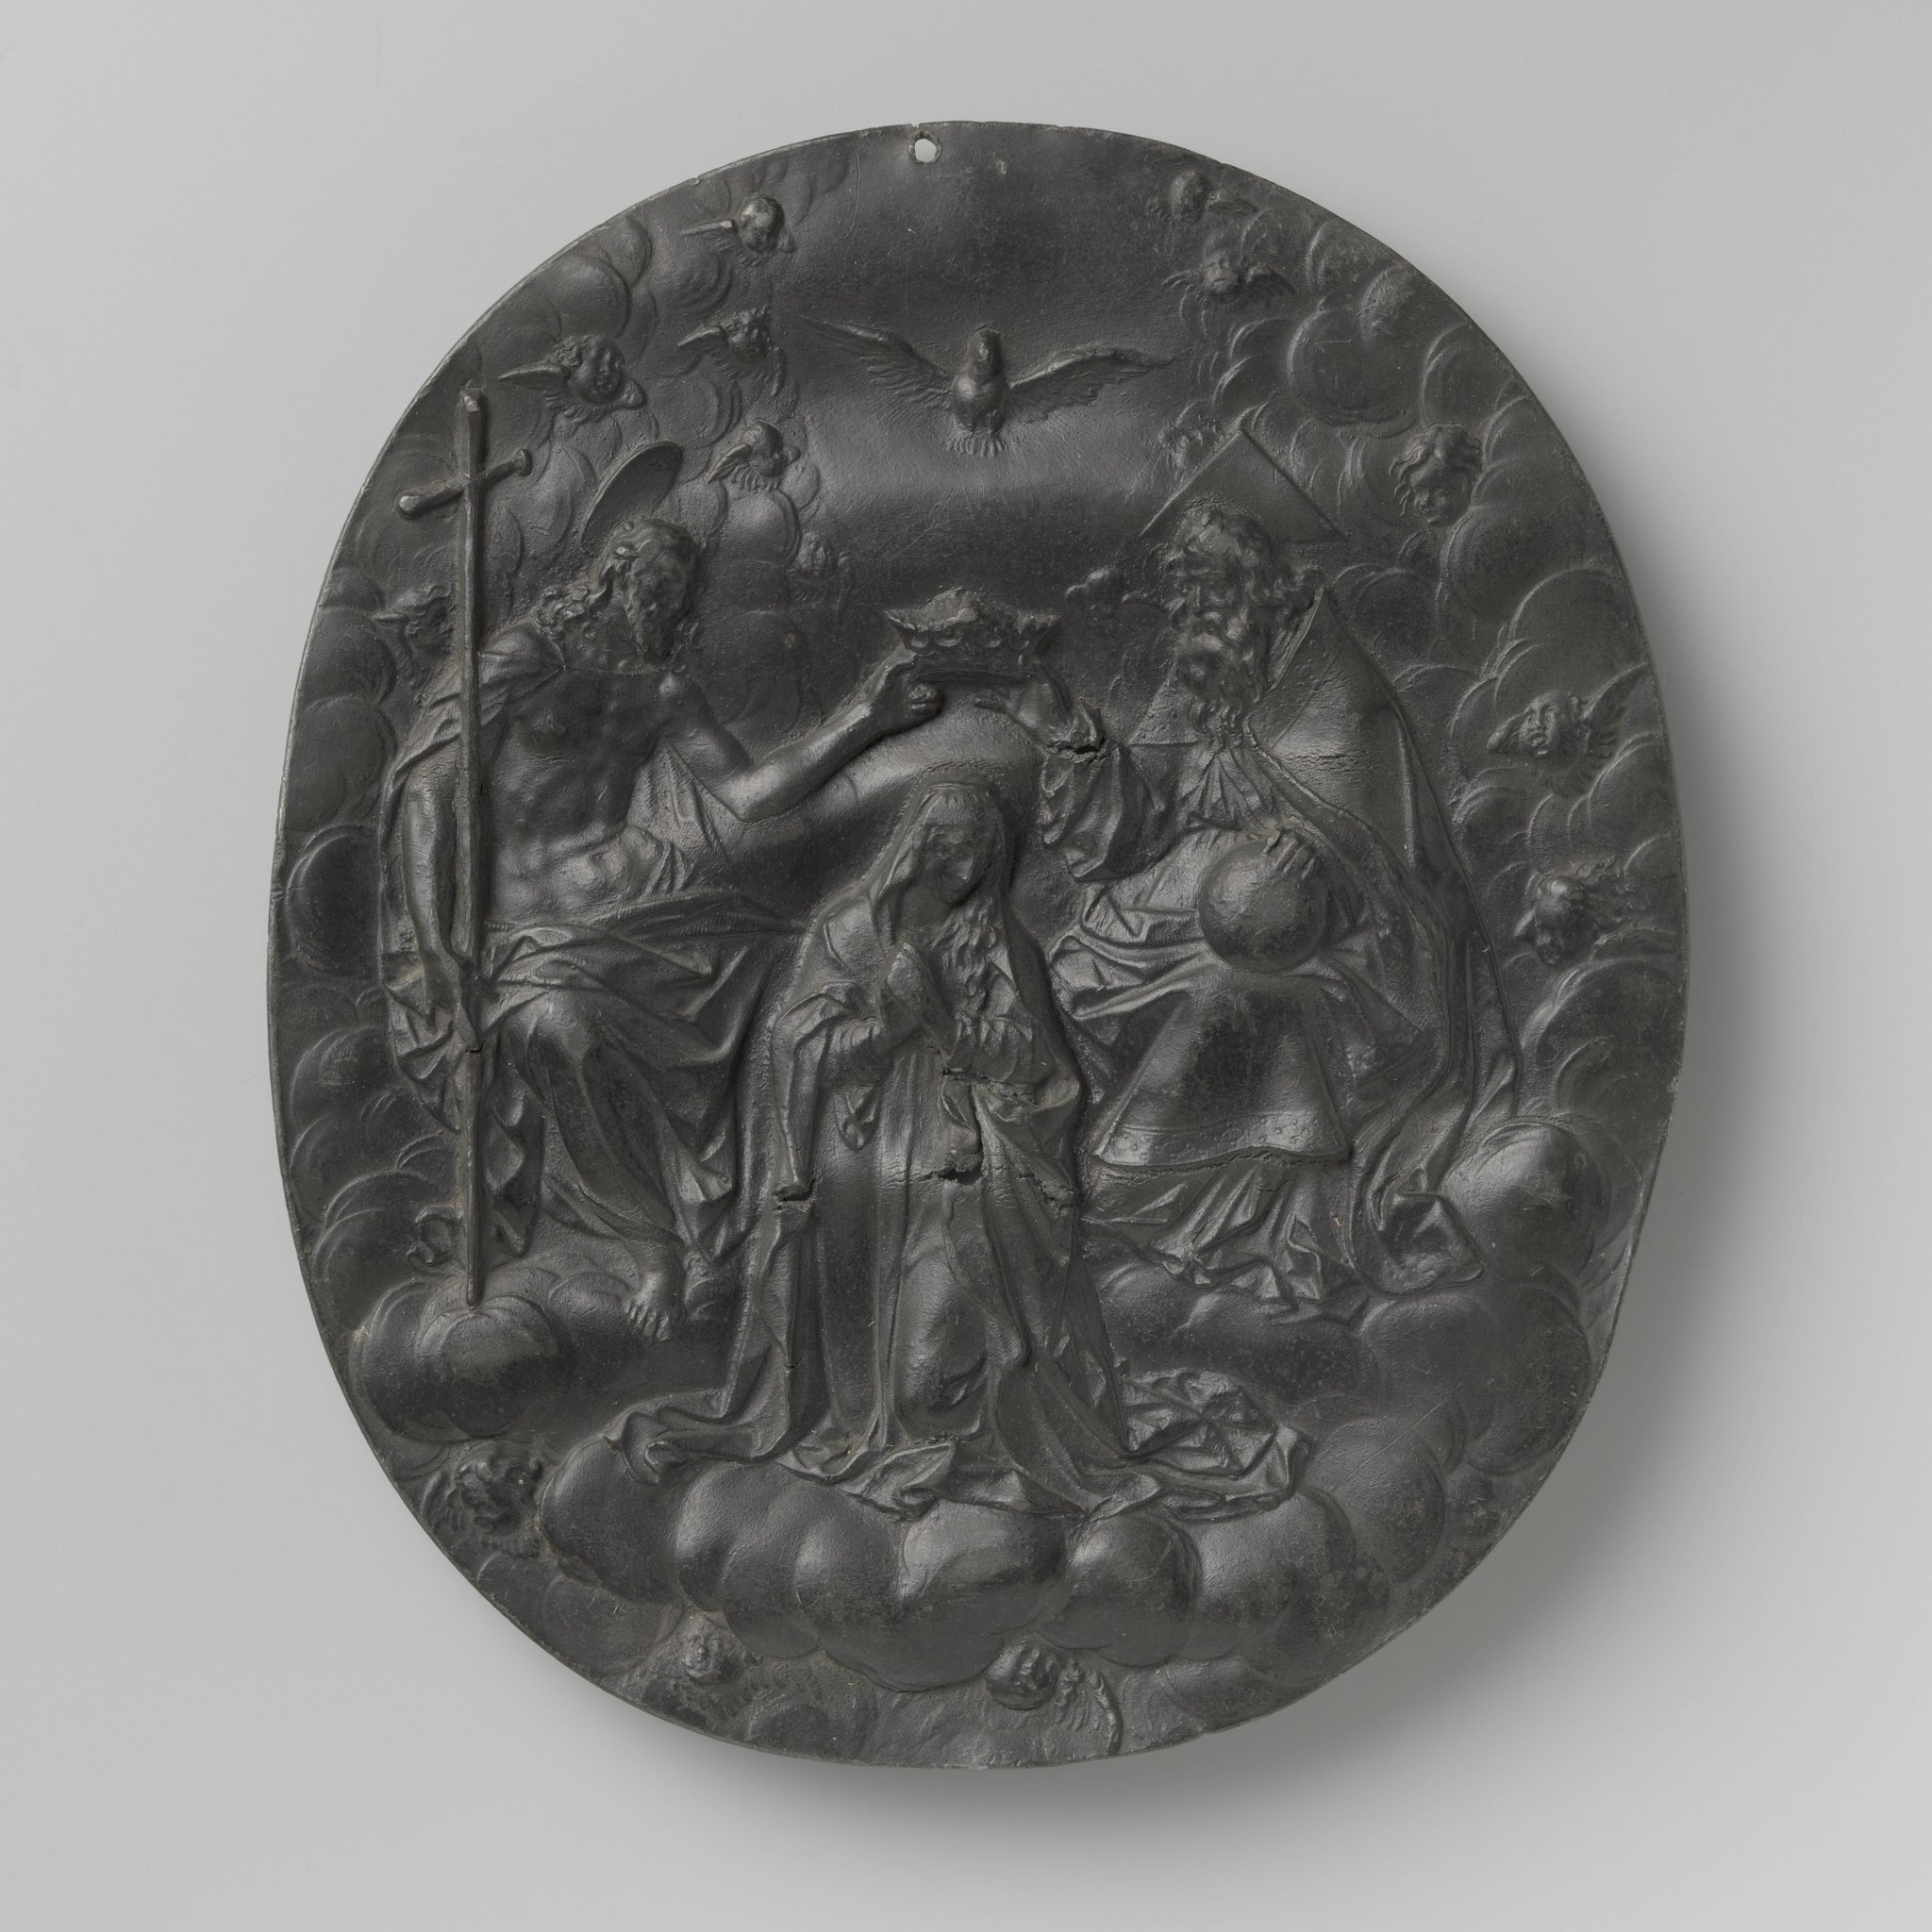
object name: model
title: Plaque met kroning Maria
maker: Anonymous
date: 1574-1599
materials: lead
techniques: repoussé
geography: southern germany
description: Model van drijfwerk in lood, voorstellende de kroning van Maria. Behorend tot set van veertien loden modellen van drijfwerk. Met de inscriptie MK.